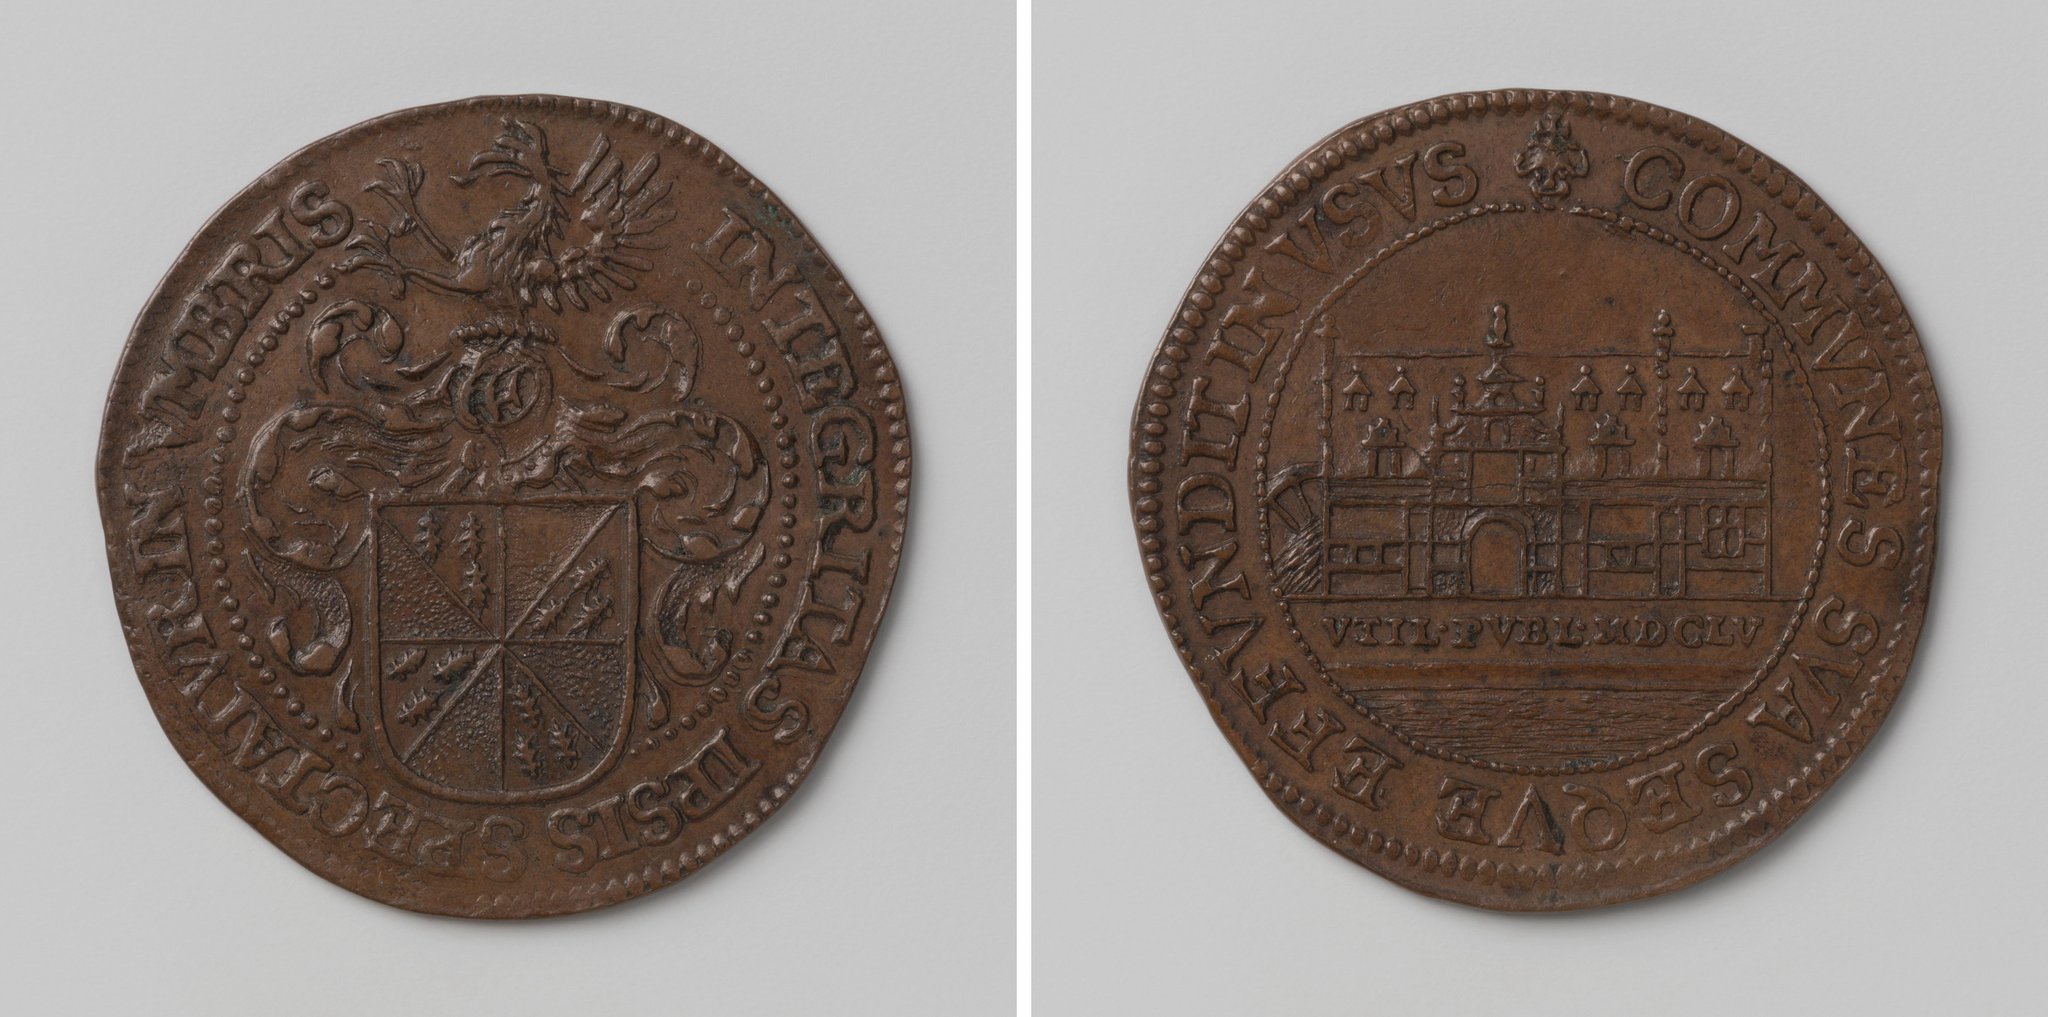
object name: jeton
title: Henri van Eesbeke, bijgenaamd Van der Haegen, magistraat van de schatkist van Brussel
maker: Anonymous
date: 1601-1655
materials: copper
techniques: striking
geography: brussels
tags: brussels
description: Koperen penning. Voorzijde: gehelmd wapenschild binnen omschrift. Keerzijde: gezicht op molen van St. Michel te Neder Heembeek; links: een waterrad boven opschrift binnen omschrift